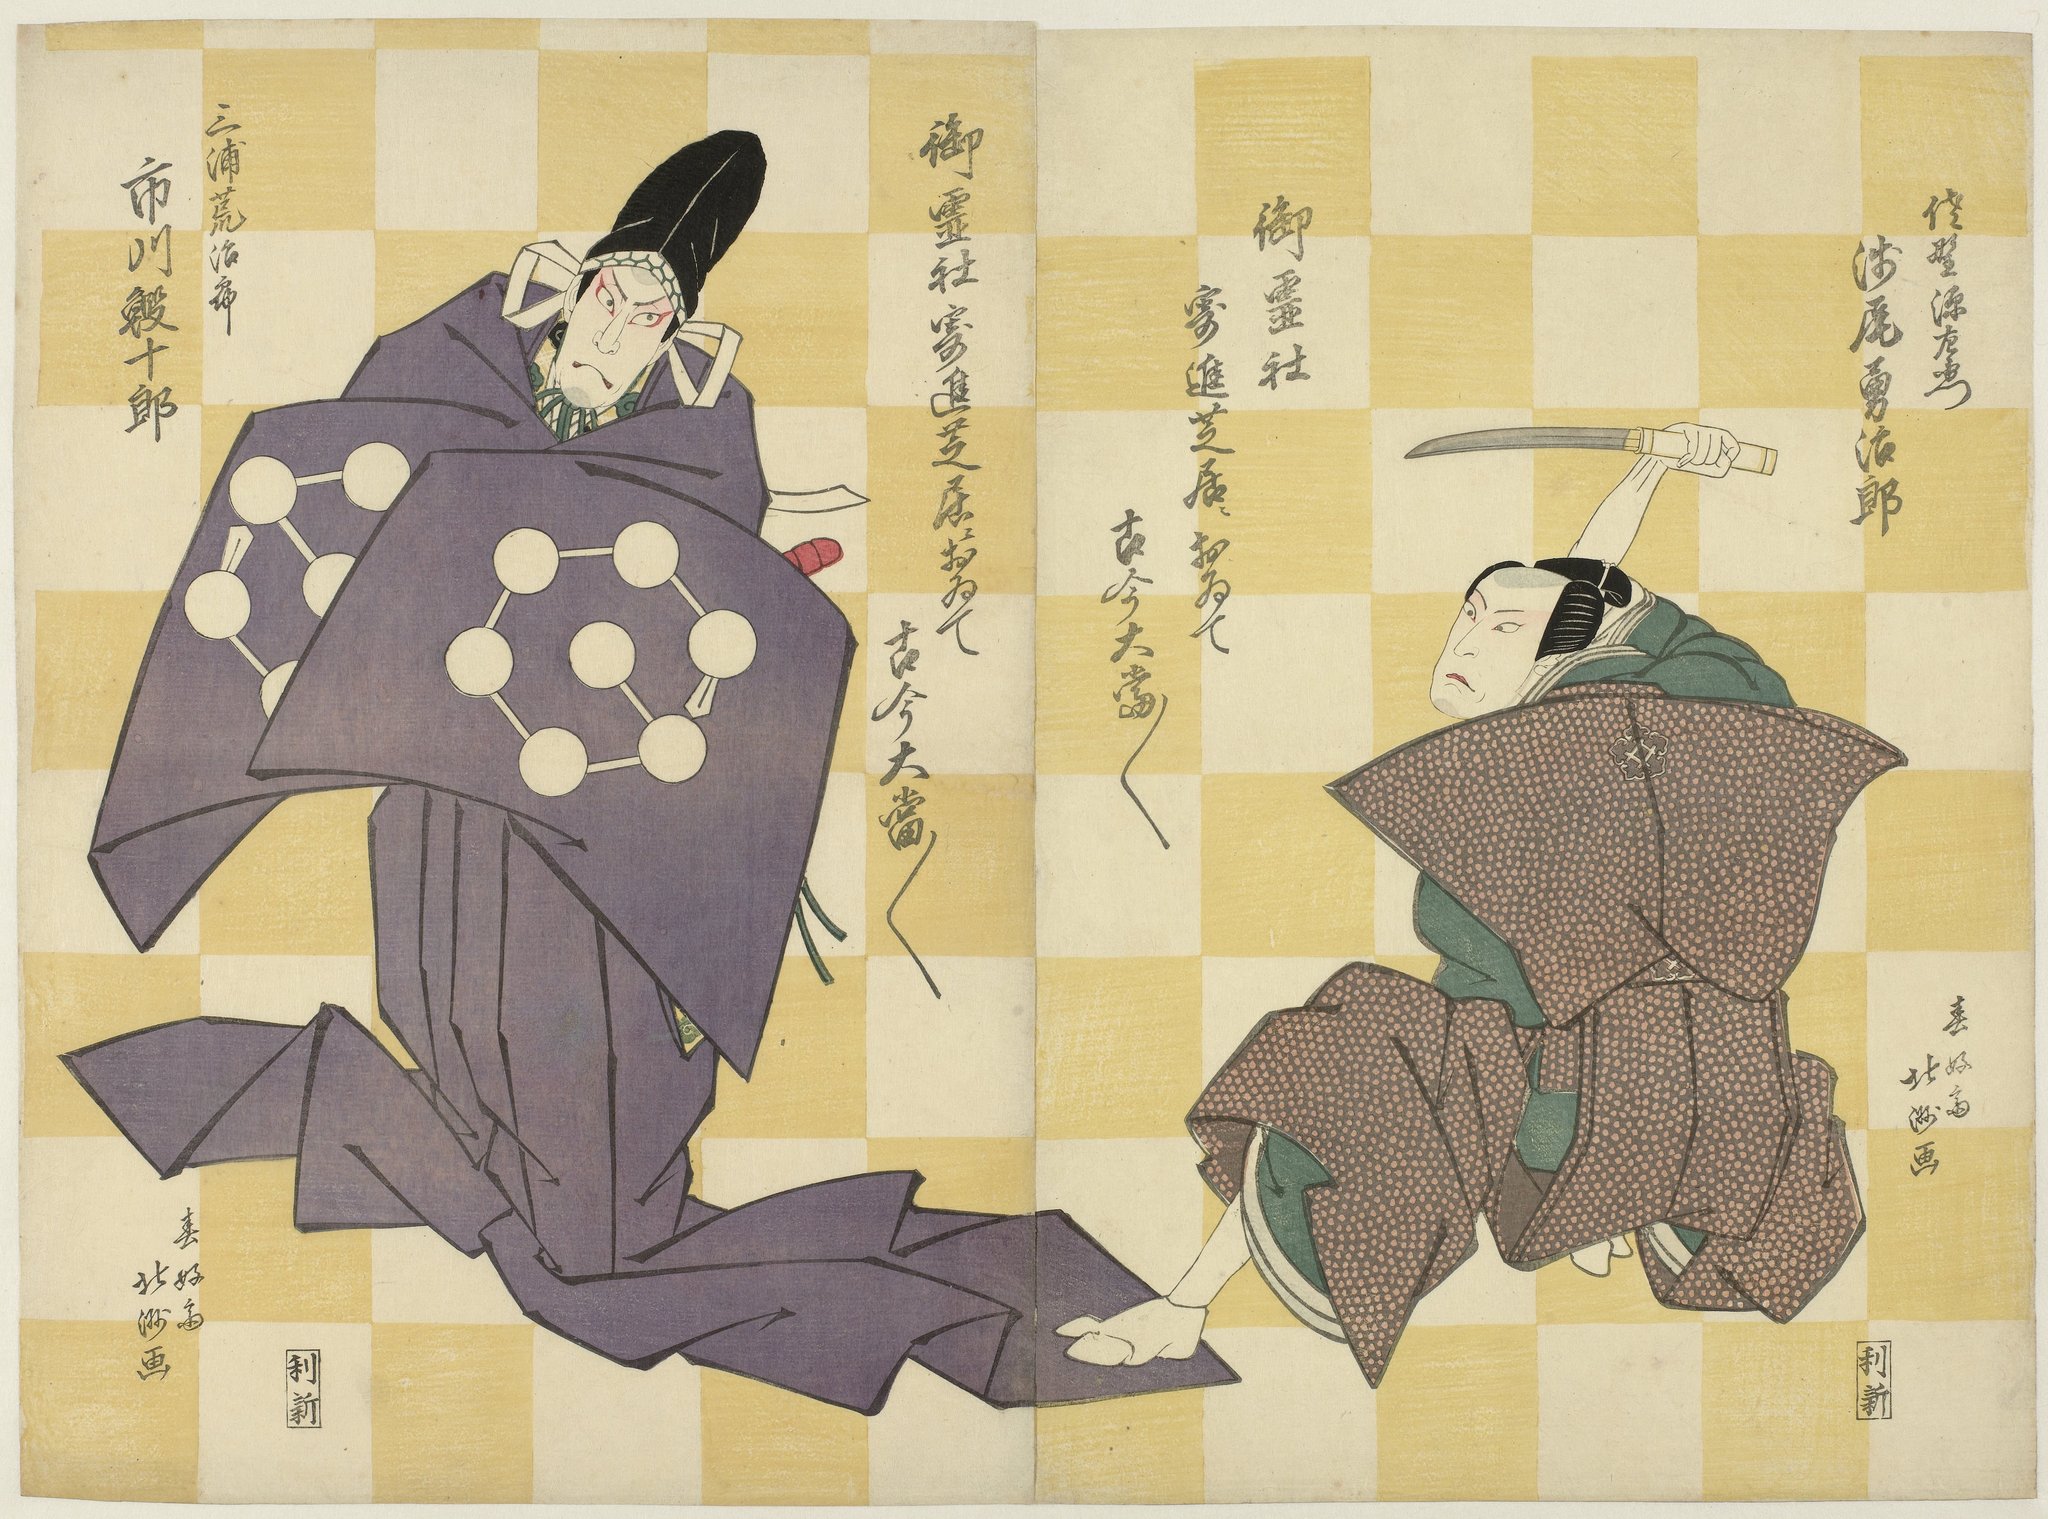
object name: print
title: Twee toneelspelers, waarvan een met mes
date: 1805-1822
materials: paper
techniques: woodcut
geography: osaka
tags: adult man (+ two persons), portrait of actor, actress, tools, aids, implements ~ crafts and industries: knife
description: Tegen een geel en wit geblokte achtergrond, staan de toneelspelers Ichikawa Ebijûrô I in paarse kimono, in de rol van Miura Arajirô en Asao Yûjirô, met mes, als Sano Genzaemon, in het stuk ‘Keisei sano no funabashi’, opgevoerd in het Goryô Theater in de vijfde maand van 1822.